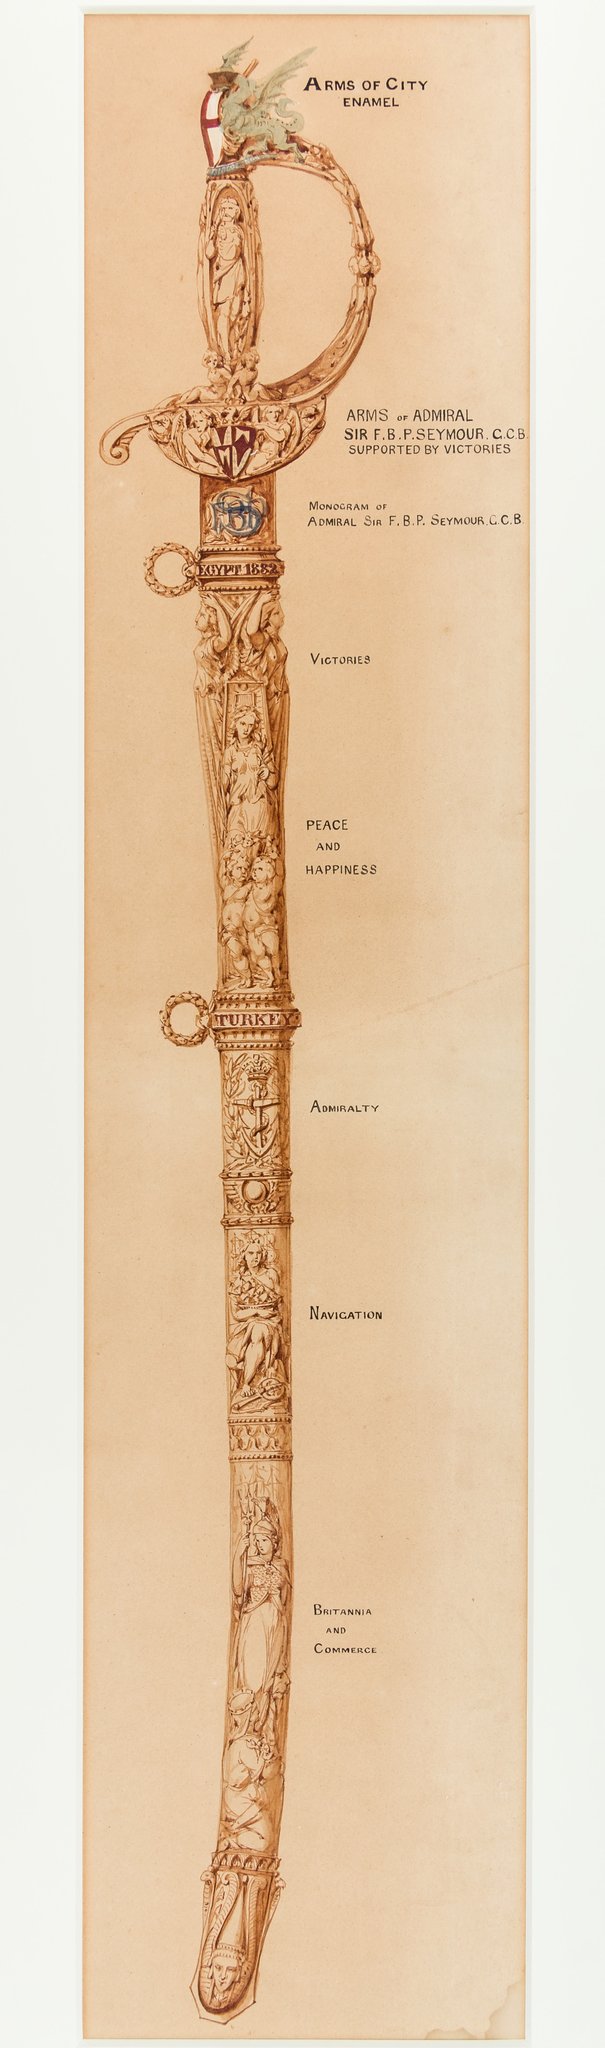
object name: two design drawing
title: Designs for a Sword of Honor to be presented by the City of London to Admiral Sir Frederick Beauchamp Paget Seymour, 1st Baron Alcester (1821–1895)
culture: british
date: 1882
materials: ink, paper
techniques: brush, pen, wash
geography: england